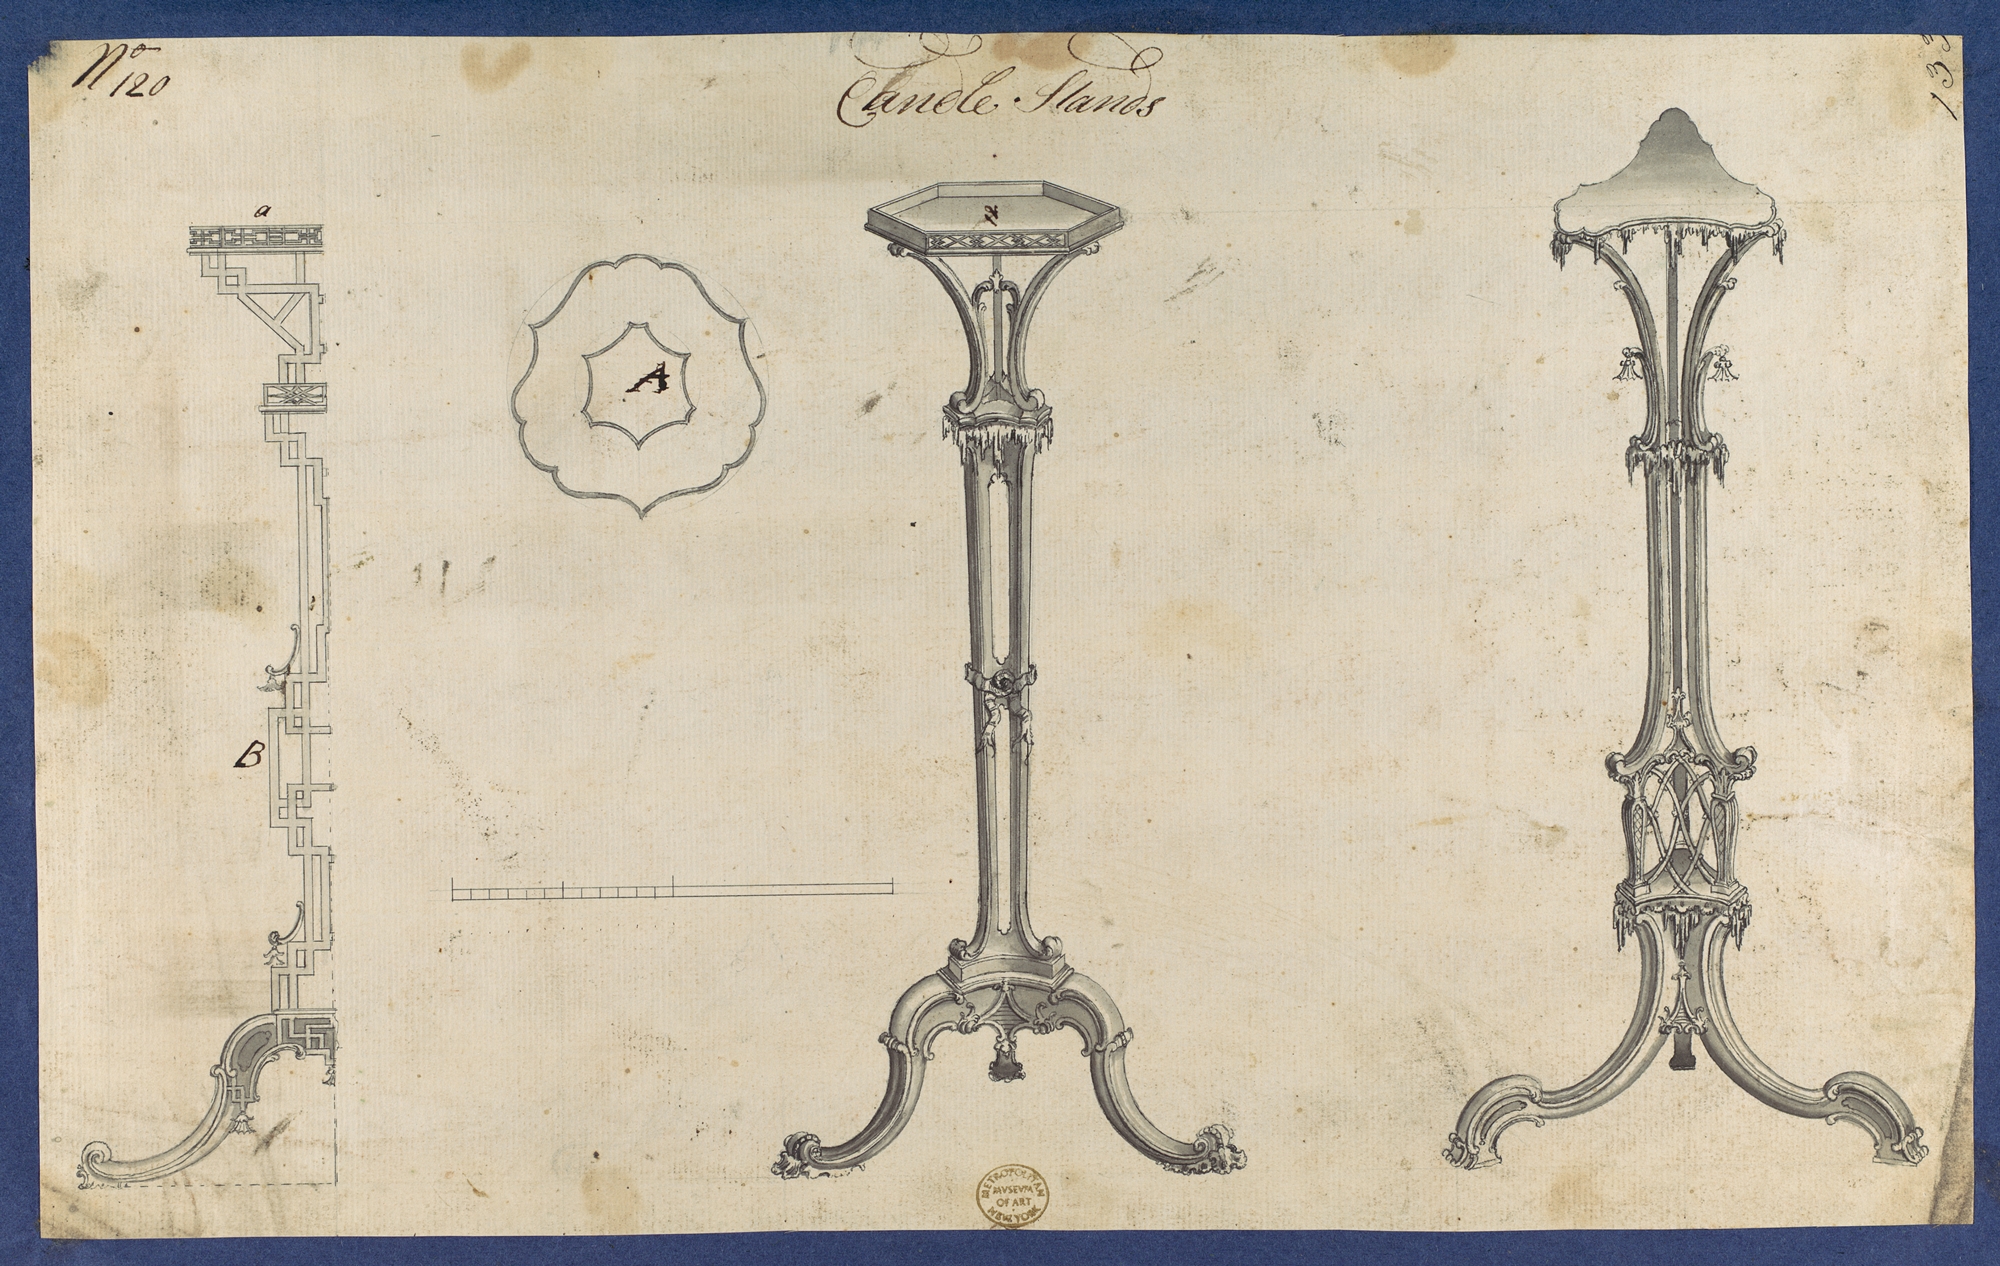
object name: drawing ornament architecture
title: Candle Stands, in Chippendale Drawings, Vol. I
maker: thomas chippendale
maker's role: artist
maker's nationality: british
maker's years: 1718-1779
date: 1753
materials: ink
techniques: wash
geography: london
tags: furniture